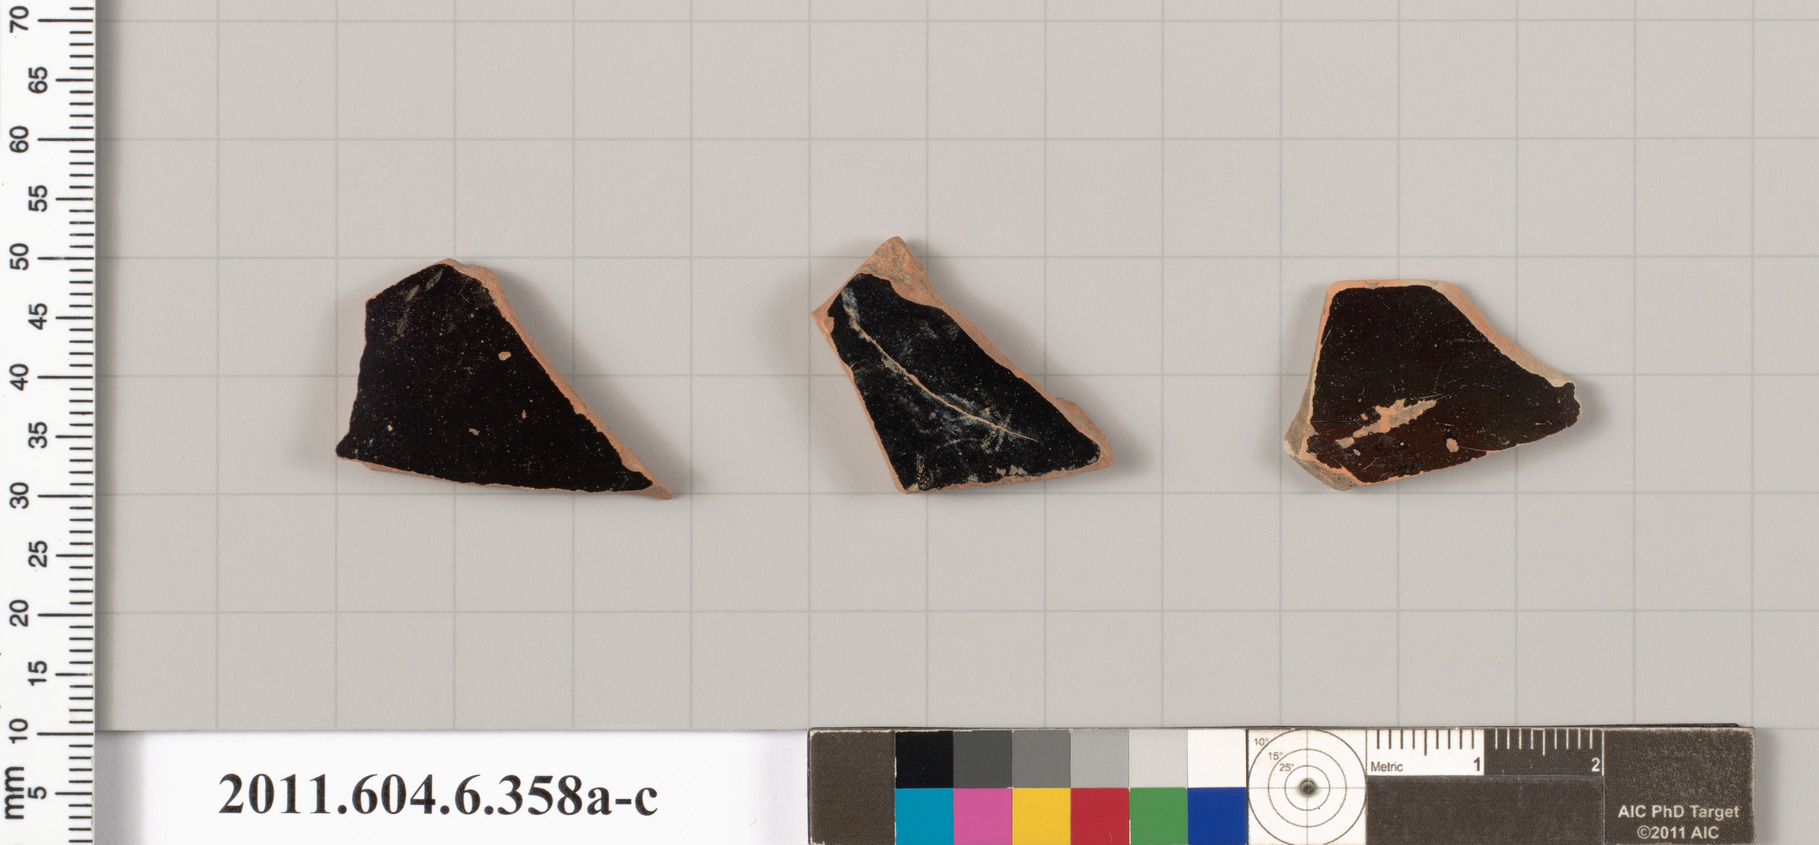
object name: undetermined closed shape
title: Terracotta fragments of closed shapes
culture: greek, attic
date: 600-401 BCE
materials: terracotta